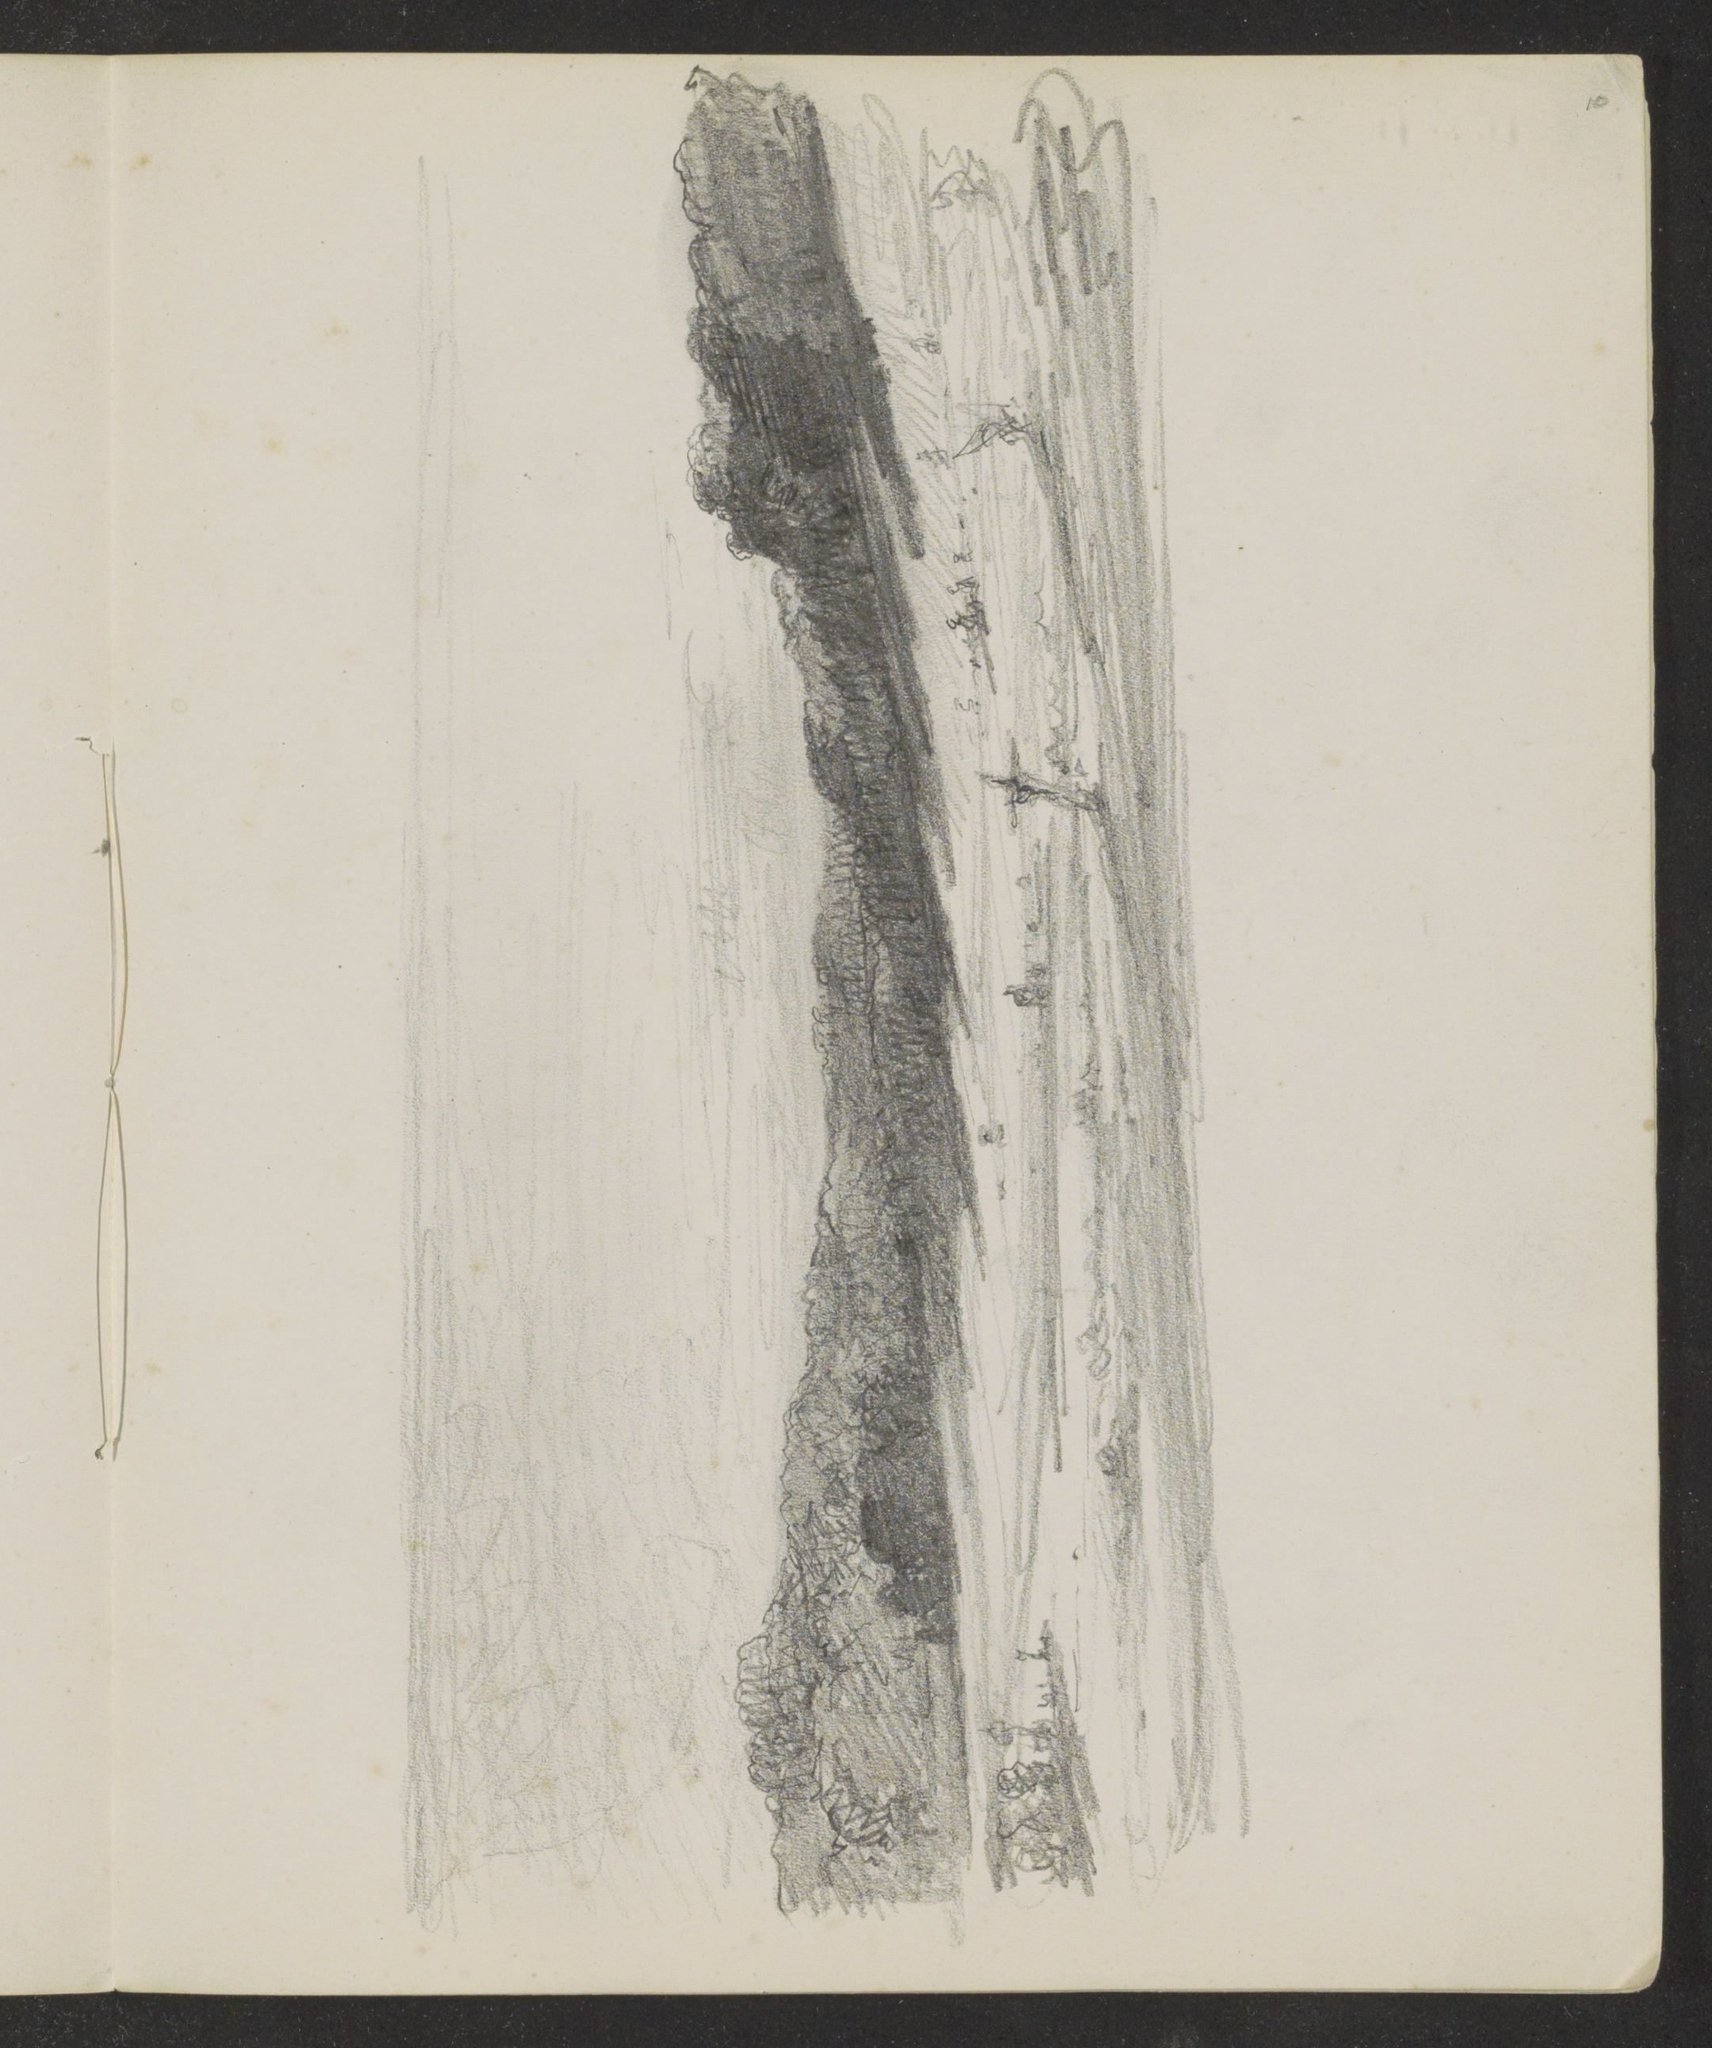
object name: sketchbook leaf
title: Landschap met bomen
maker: maria vos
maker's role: draughtsman, painter, print maker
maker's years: 1824-1906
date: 1886-1890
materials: paper, pencil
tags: landscapes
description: Blad 10 recto uit een schetsboek met 17 bladen.